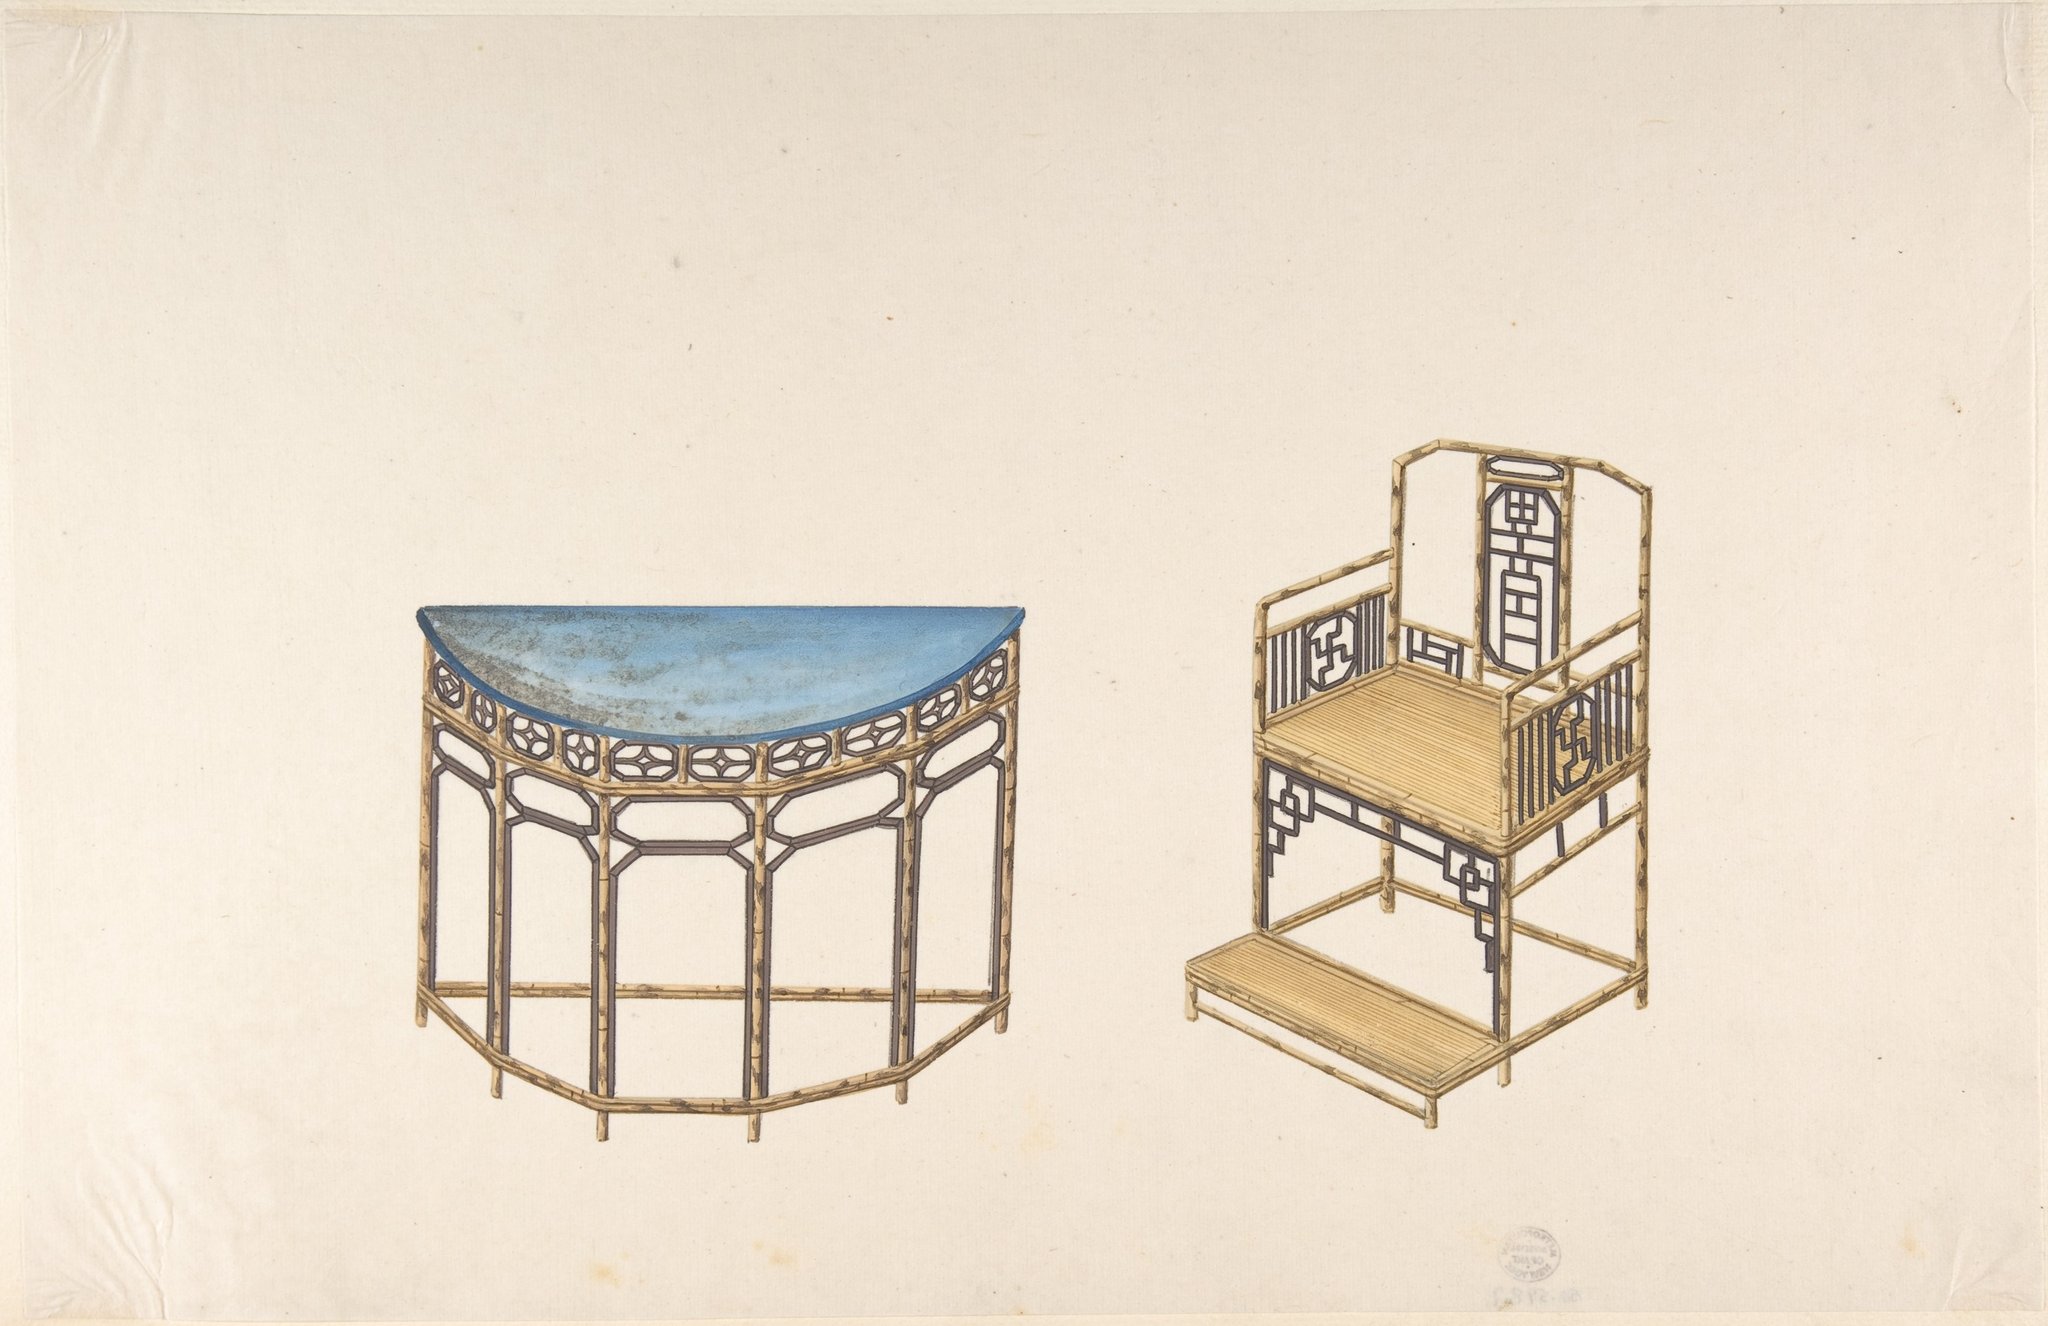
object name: drawing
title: Design for Export Furniture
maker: anonymous, chinese, 19th century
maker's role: artist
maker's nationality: chinese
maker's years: 1800-1900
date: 1800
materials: graphite, watercolor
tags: chairs